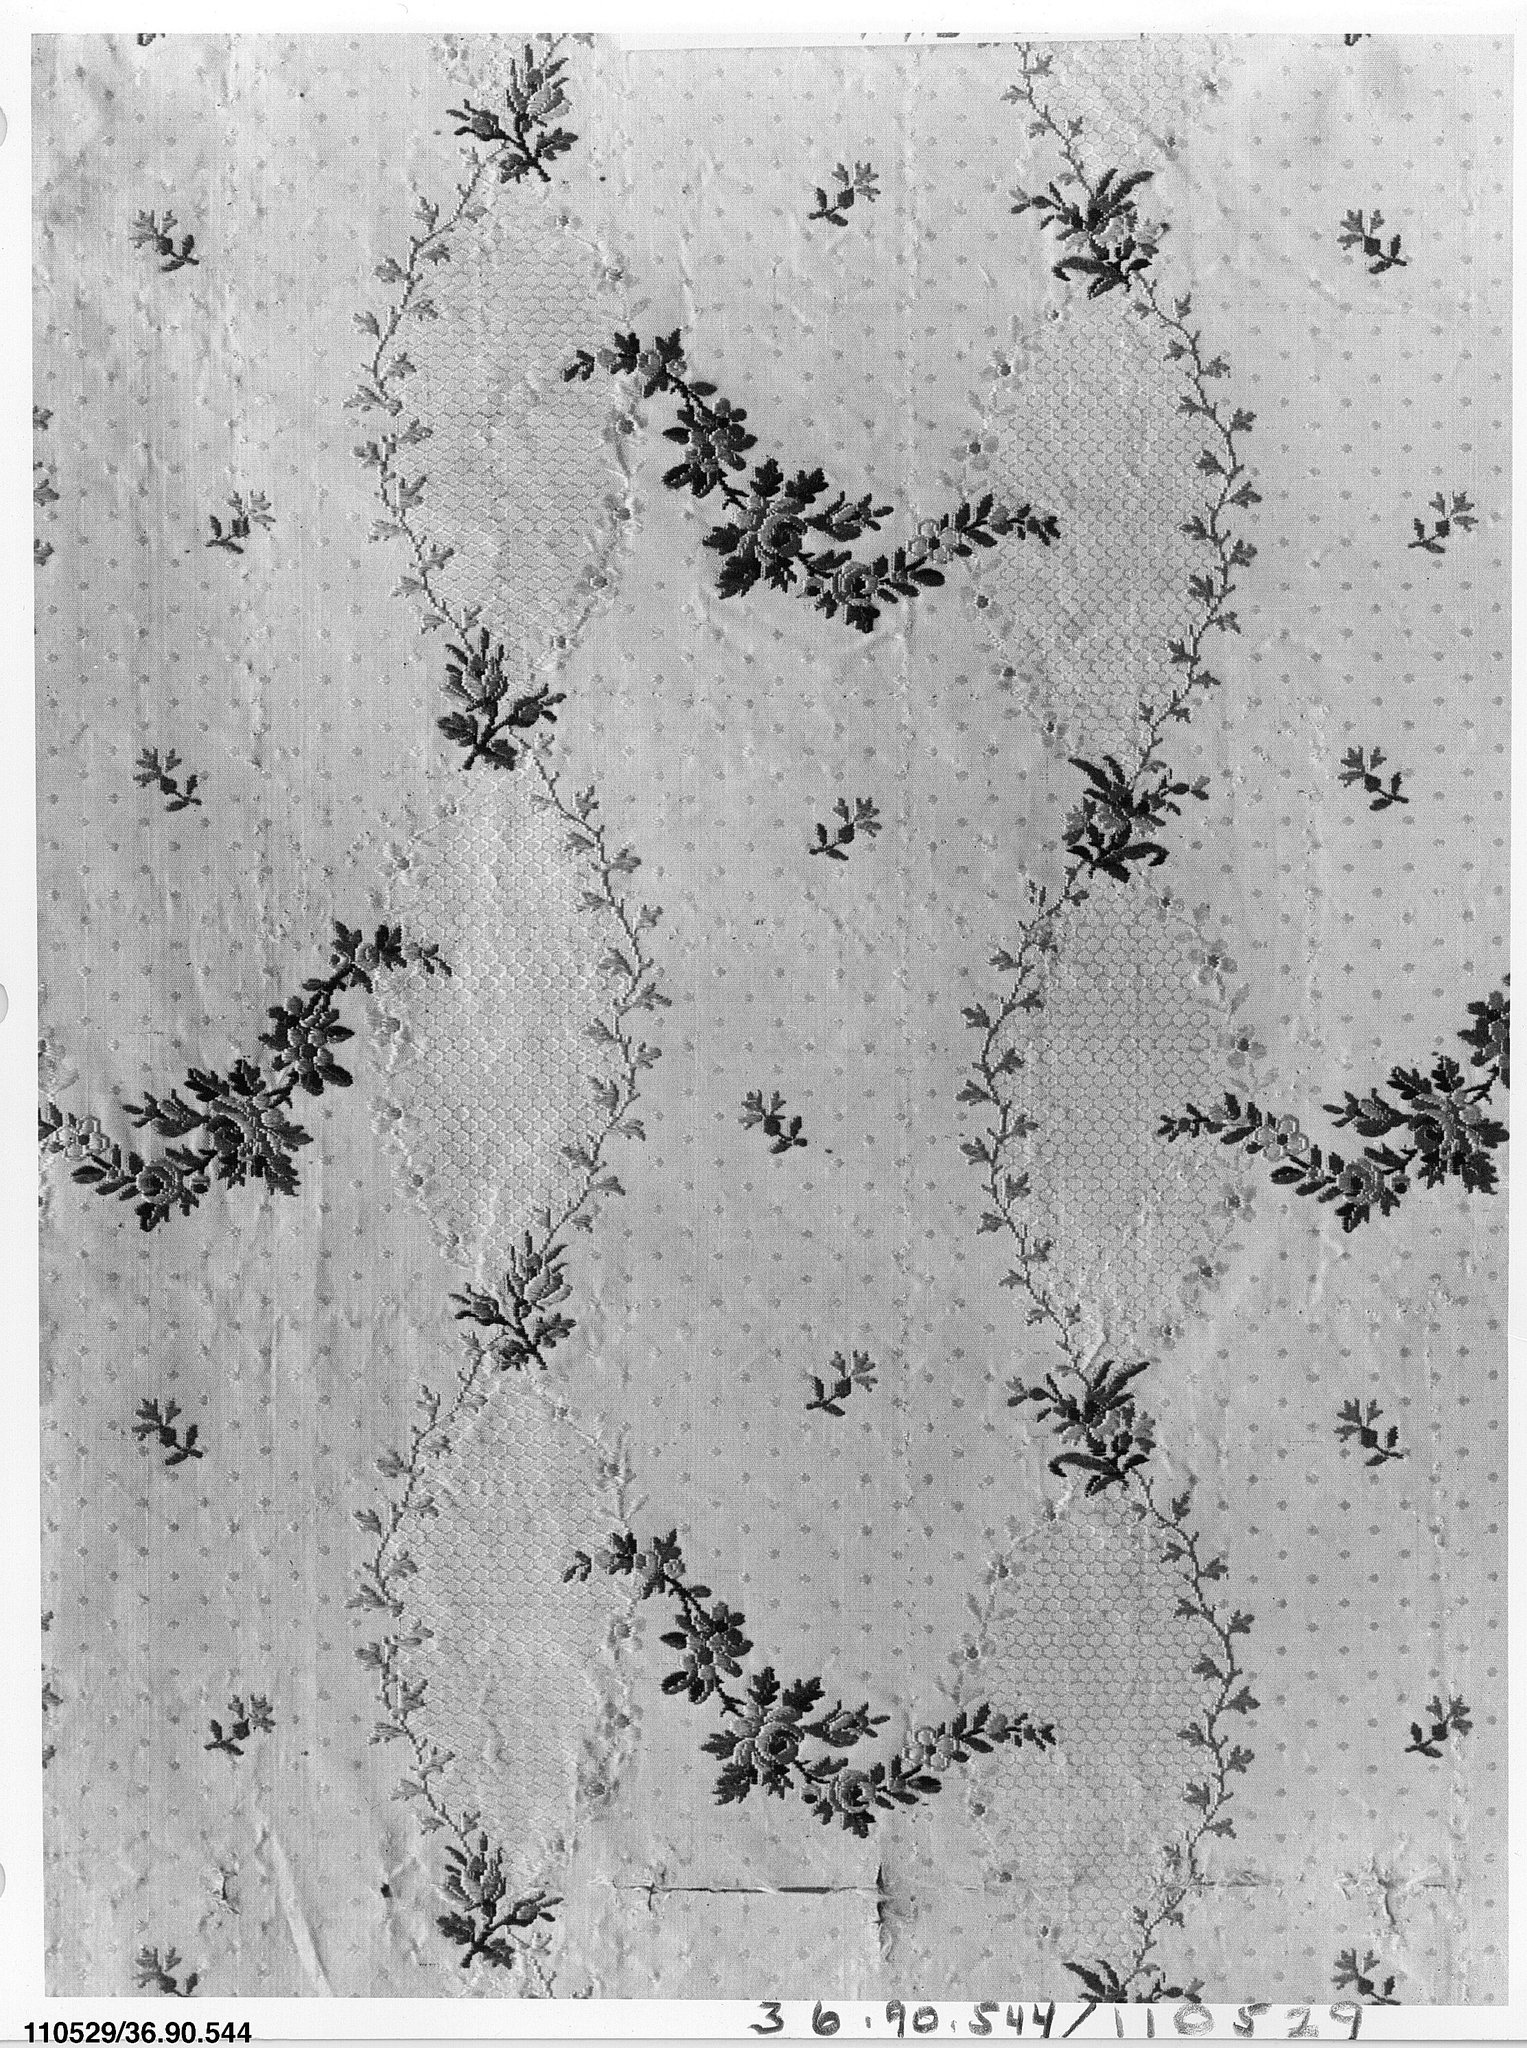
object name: piece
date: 1767-1800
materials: silk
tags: flowers,leaves